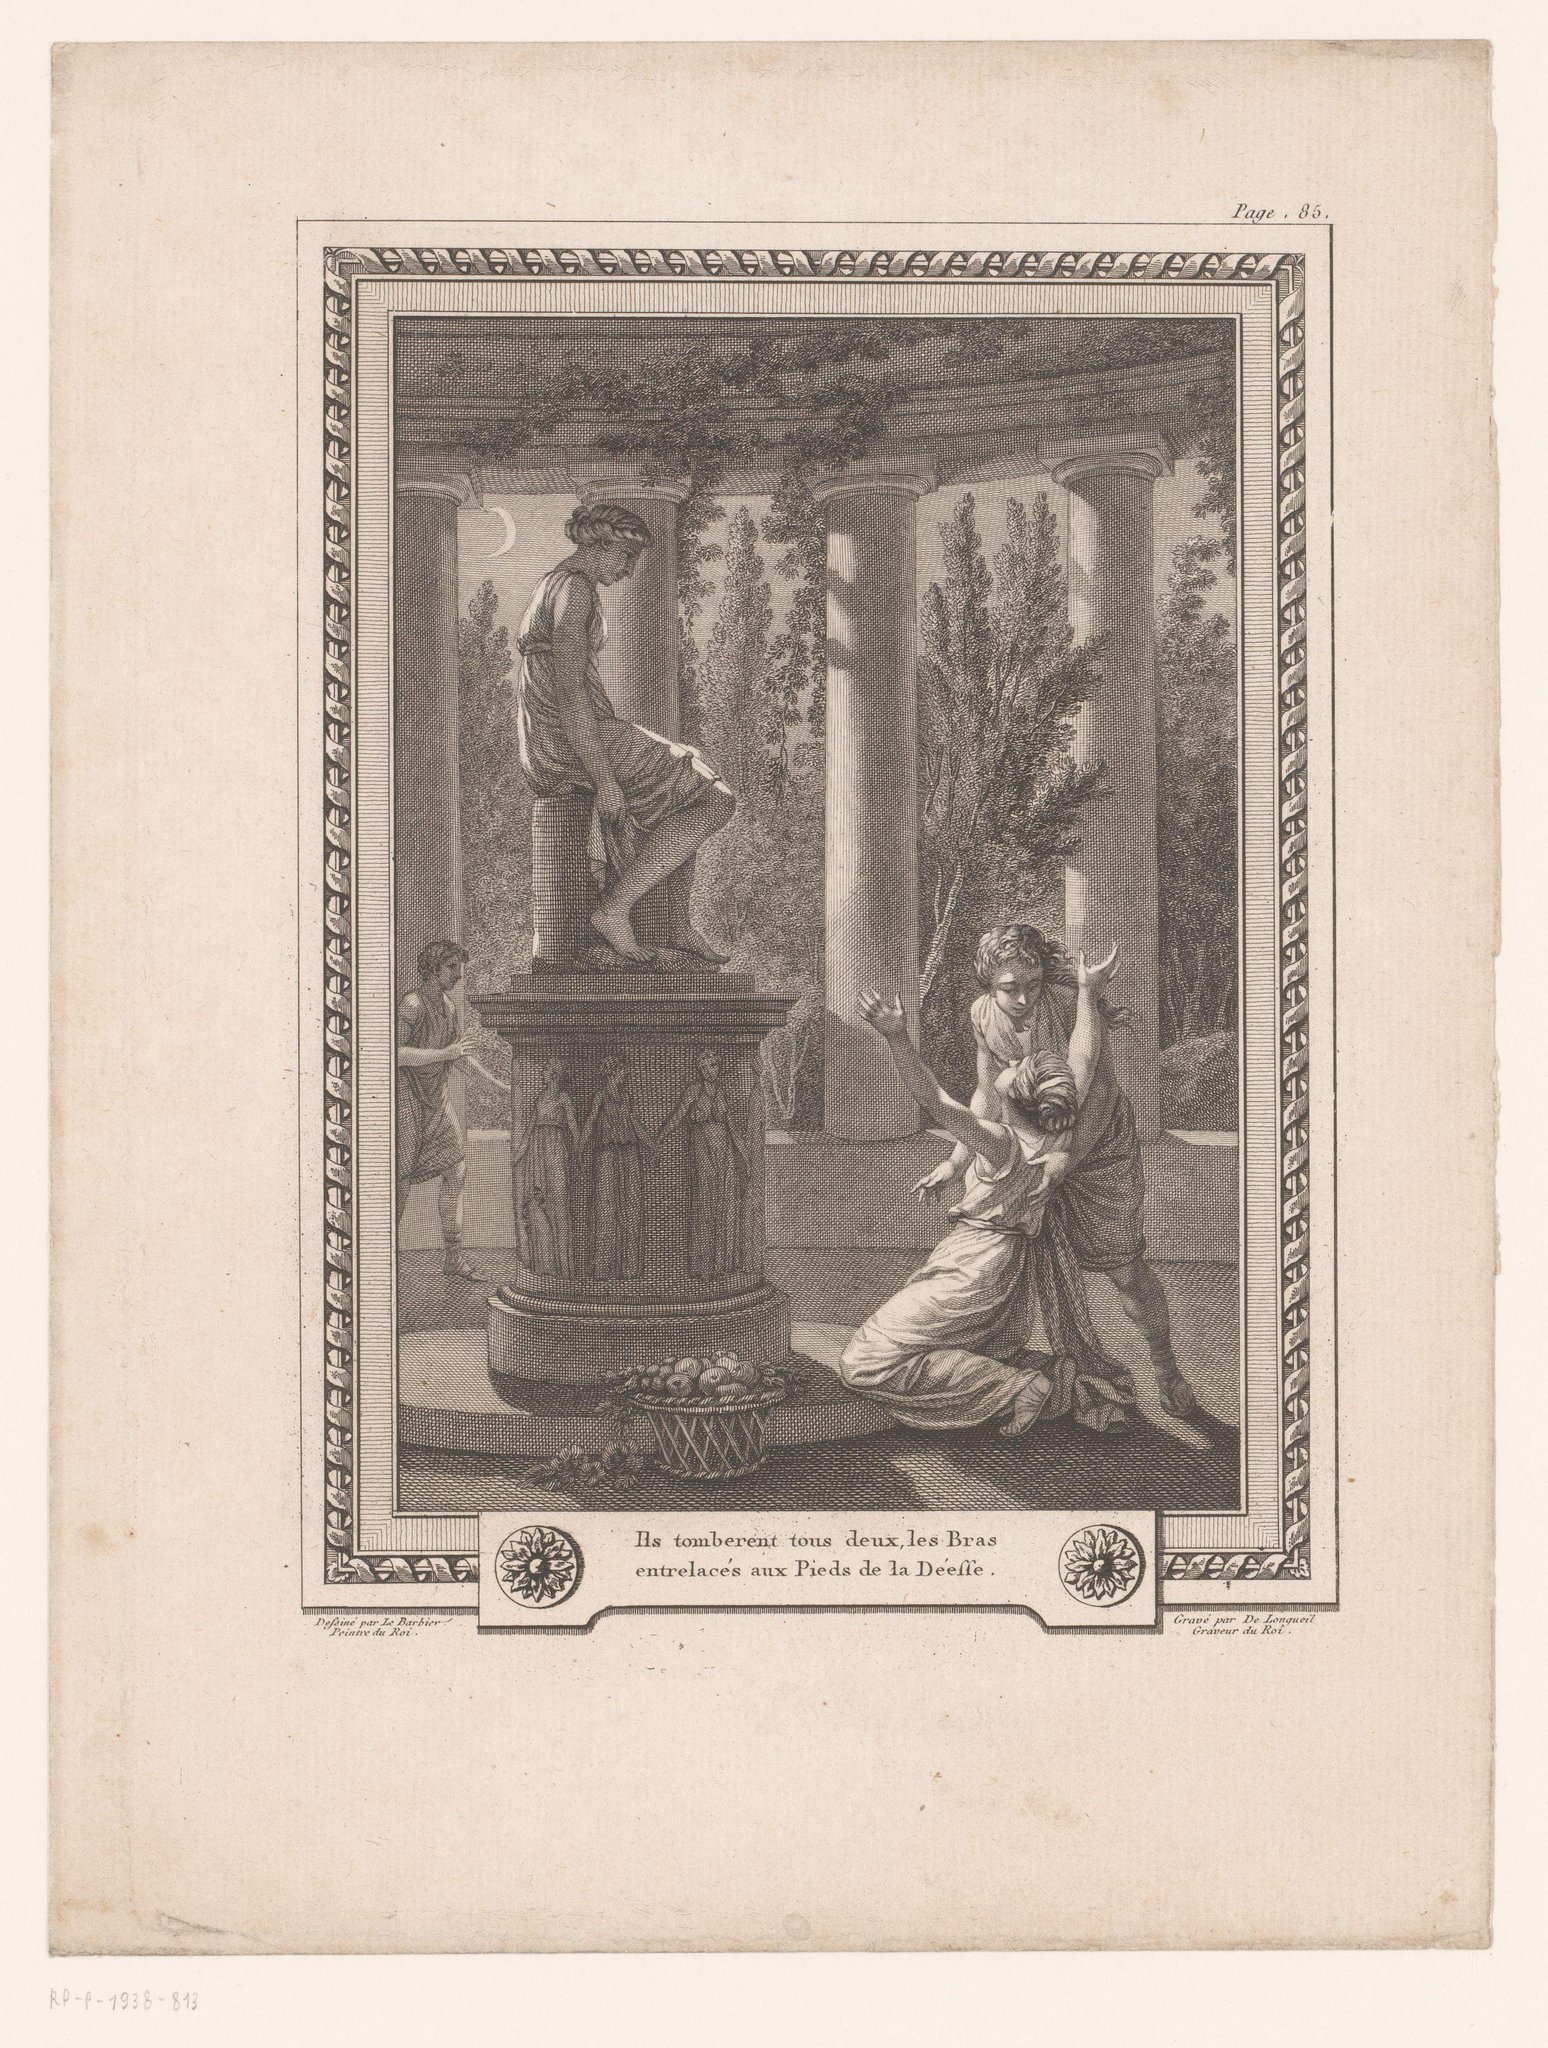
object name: book illustration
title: Twee vrouwen voor een standbeeld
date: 1740-1792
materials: paper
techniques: engraving, etching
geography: france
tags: kneeling figure - aa - female human figure, monument, statue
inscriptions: collector's mark: Lugt 2228